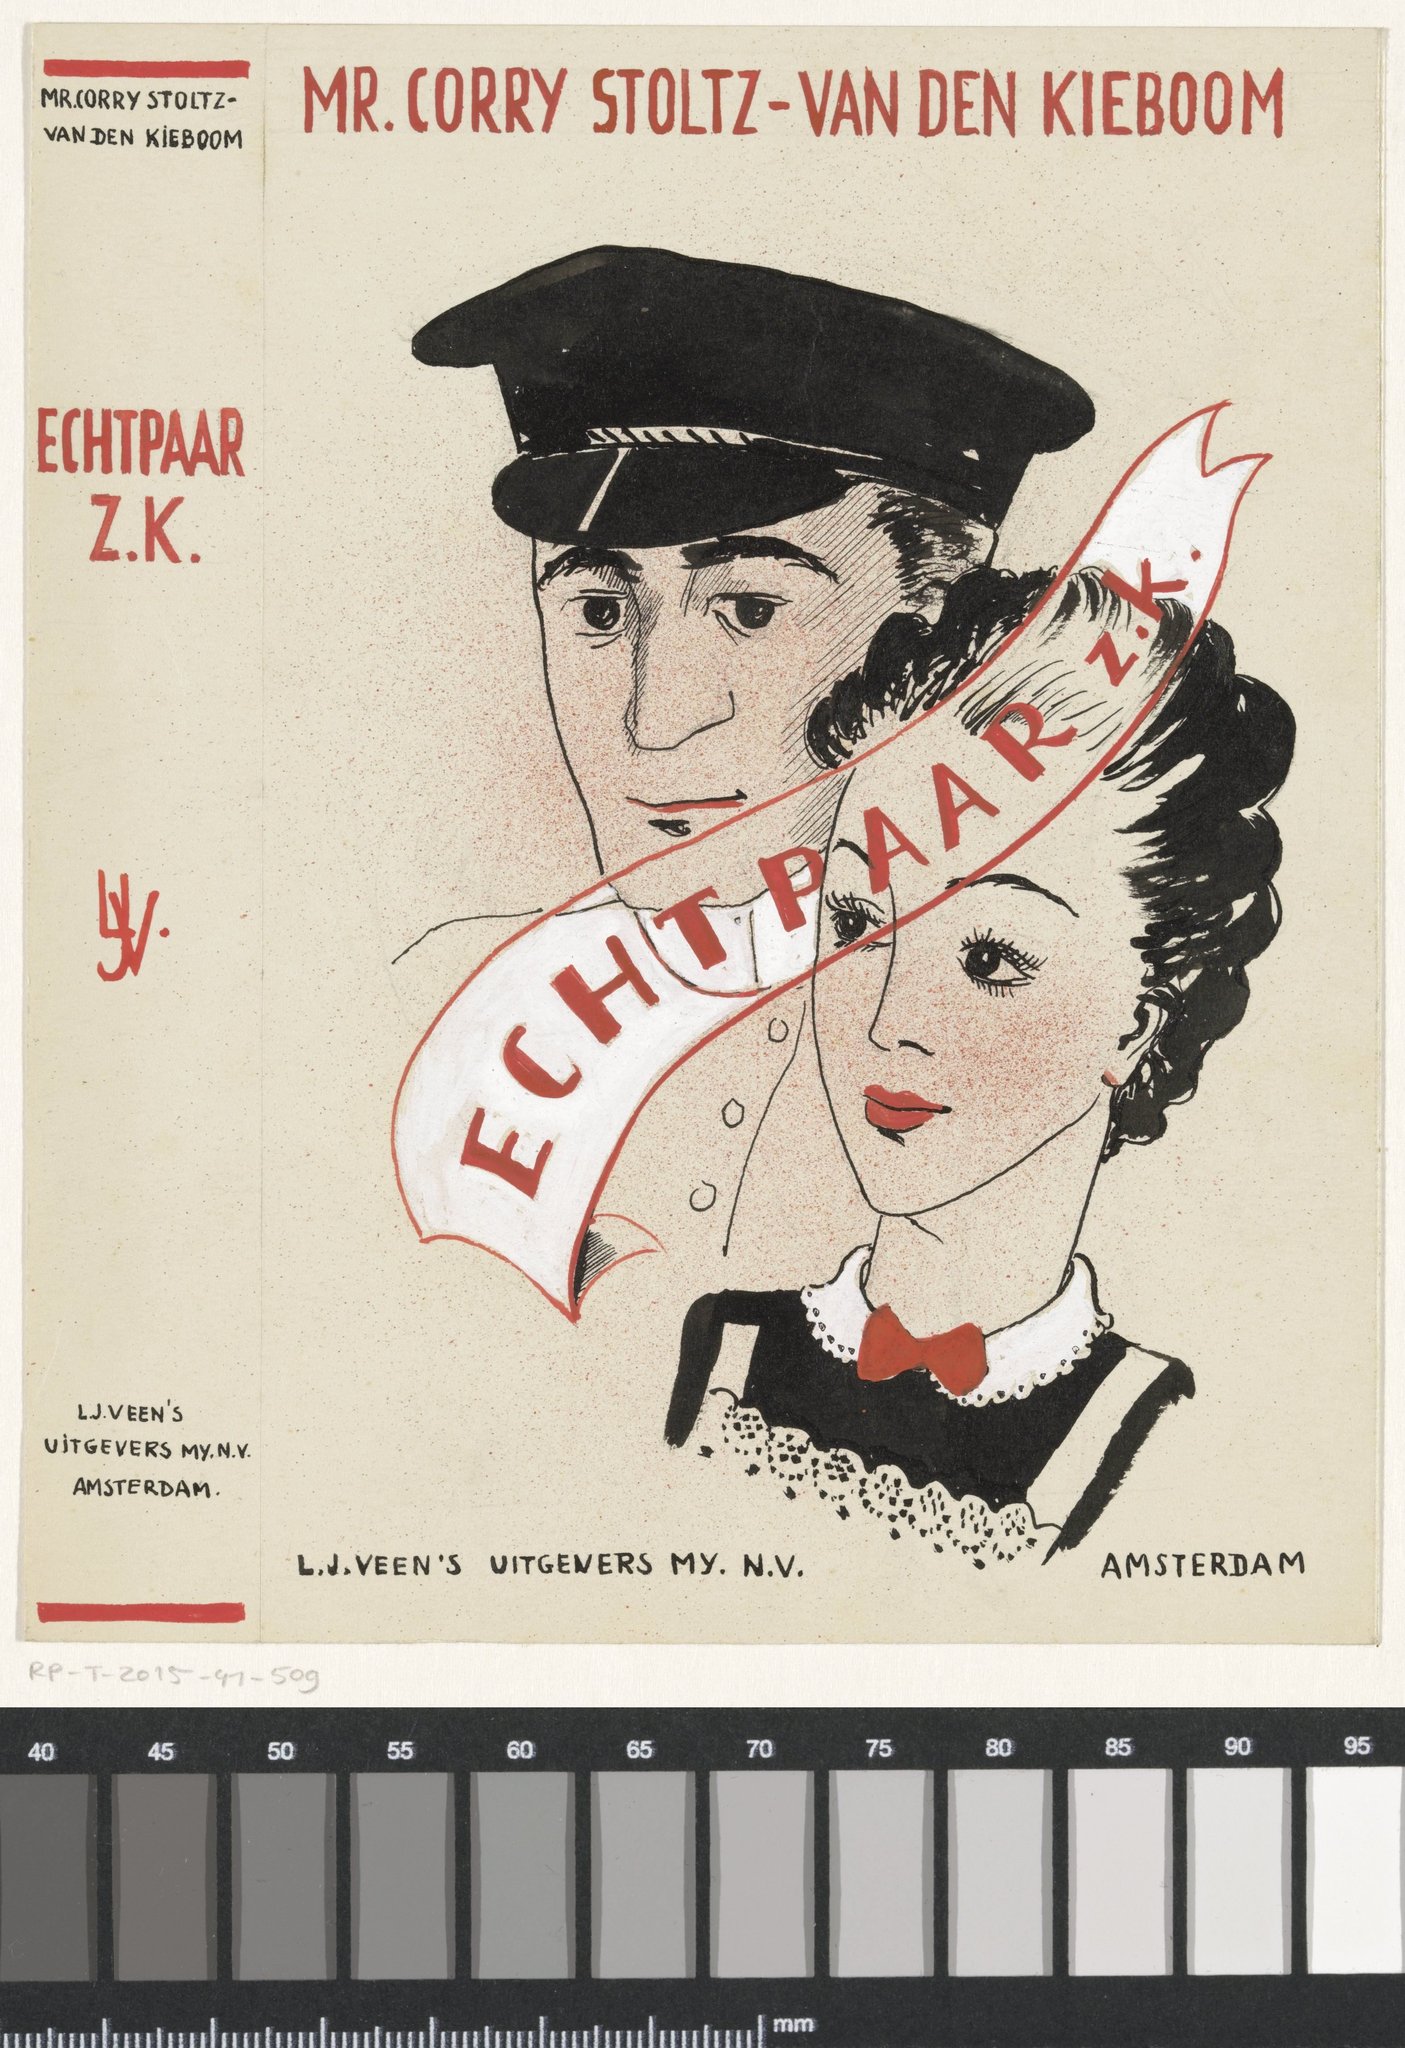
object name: drawing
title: Bandontwerp voor: Corry Stoltz-Van den Kieboom, Echtpaar z.k., 1936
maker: g. hagemeyer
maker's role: illustrator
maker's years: -1958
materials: paint, ink, paper, pencil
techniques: brush, pen, spatter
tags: head (human), marriage, married couple, 'matrimonium', flags (~ signalling)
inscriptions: collector's mark: Lugt 2228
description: Koppen van een echtpaar. De man draagt een pet en jas met knopen, de vrouw een schort. Voor hun gezichten een banier met de boektitel. Op de boekrug het logo van Veen's Uitgeversmaatschappij.